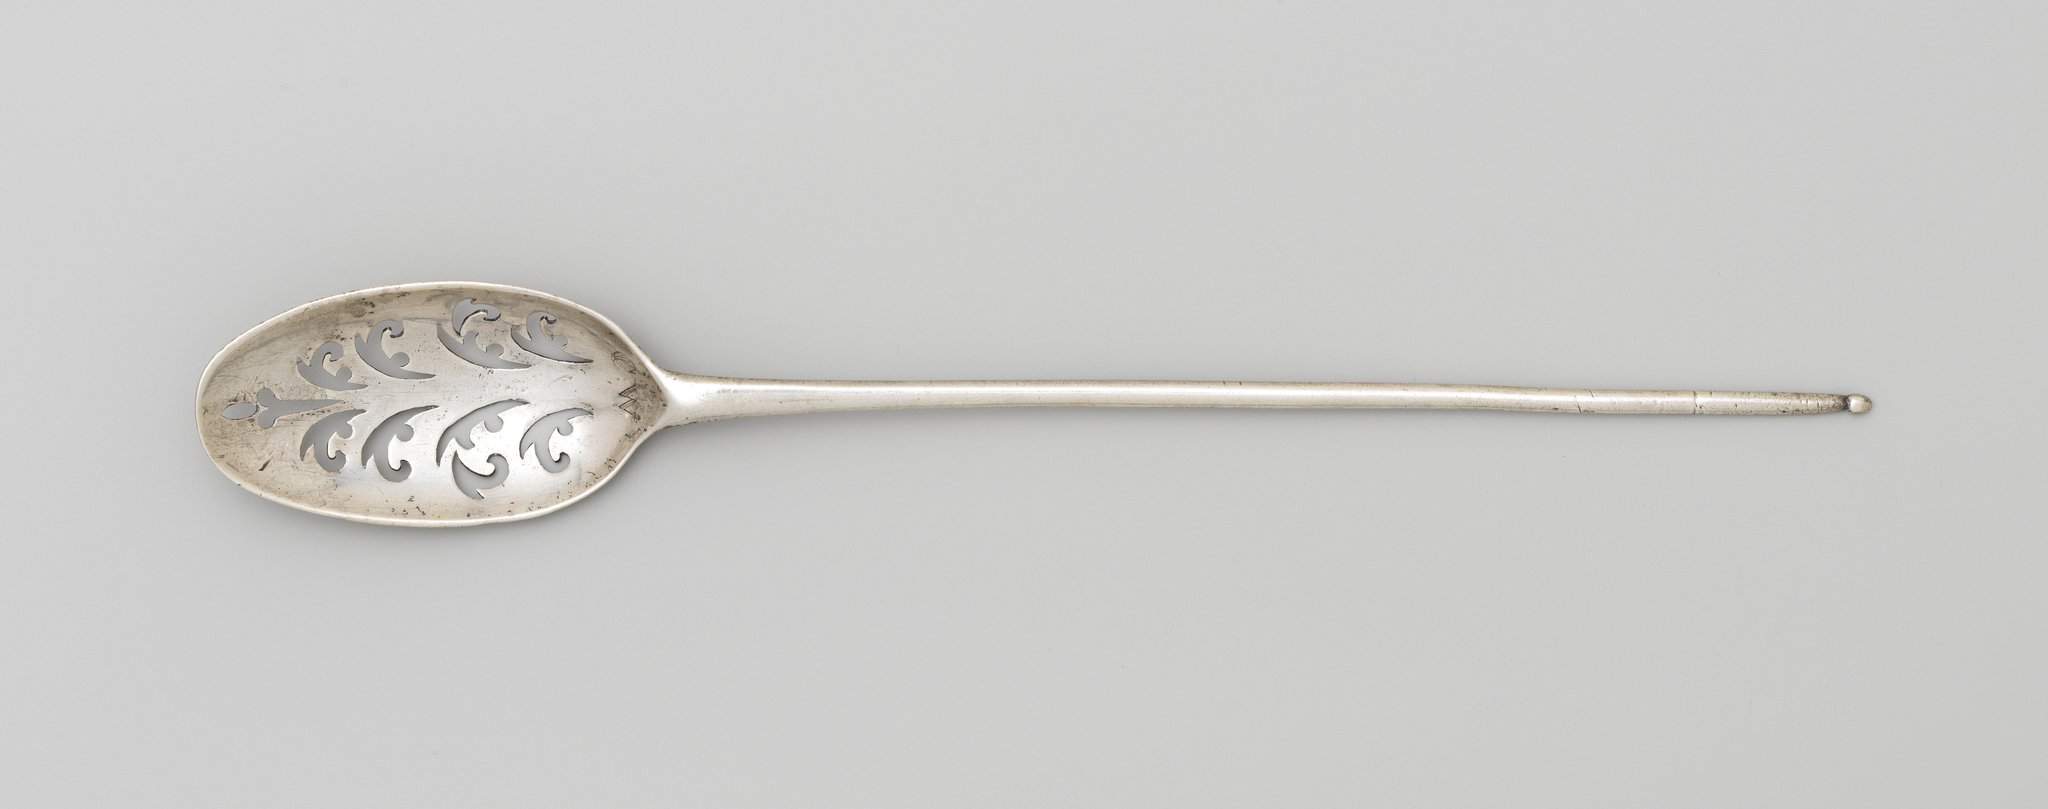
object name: strainer spoon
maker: elizabeth tookey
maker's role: maker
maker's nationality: british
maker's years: 1773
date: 1701-1800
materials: silver